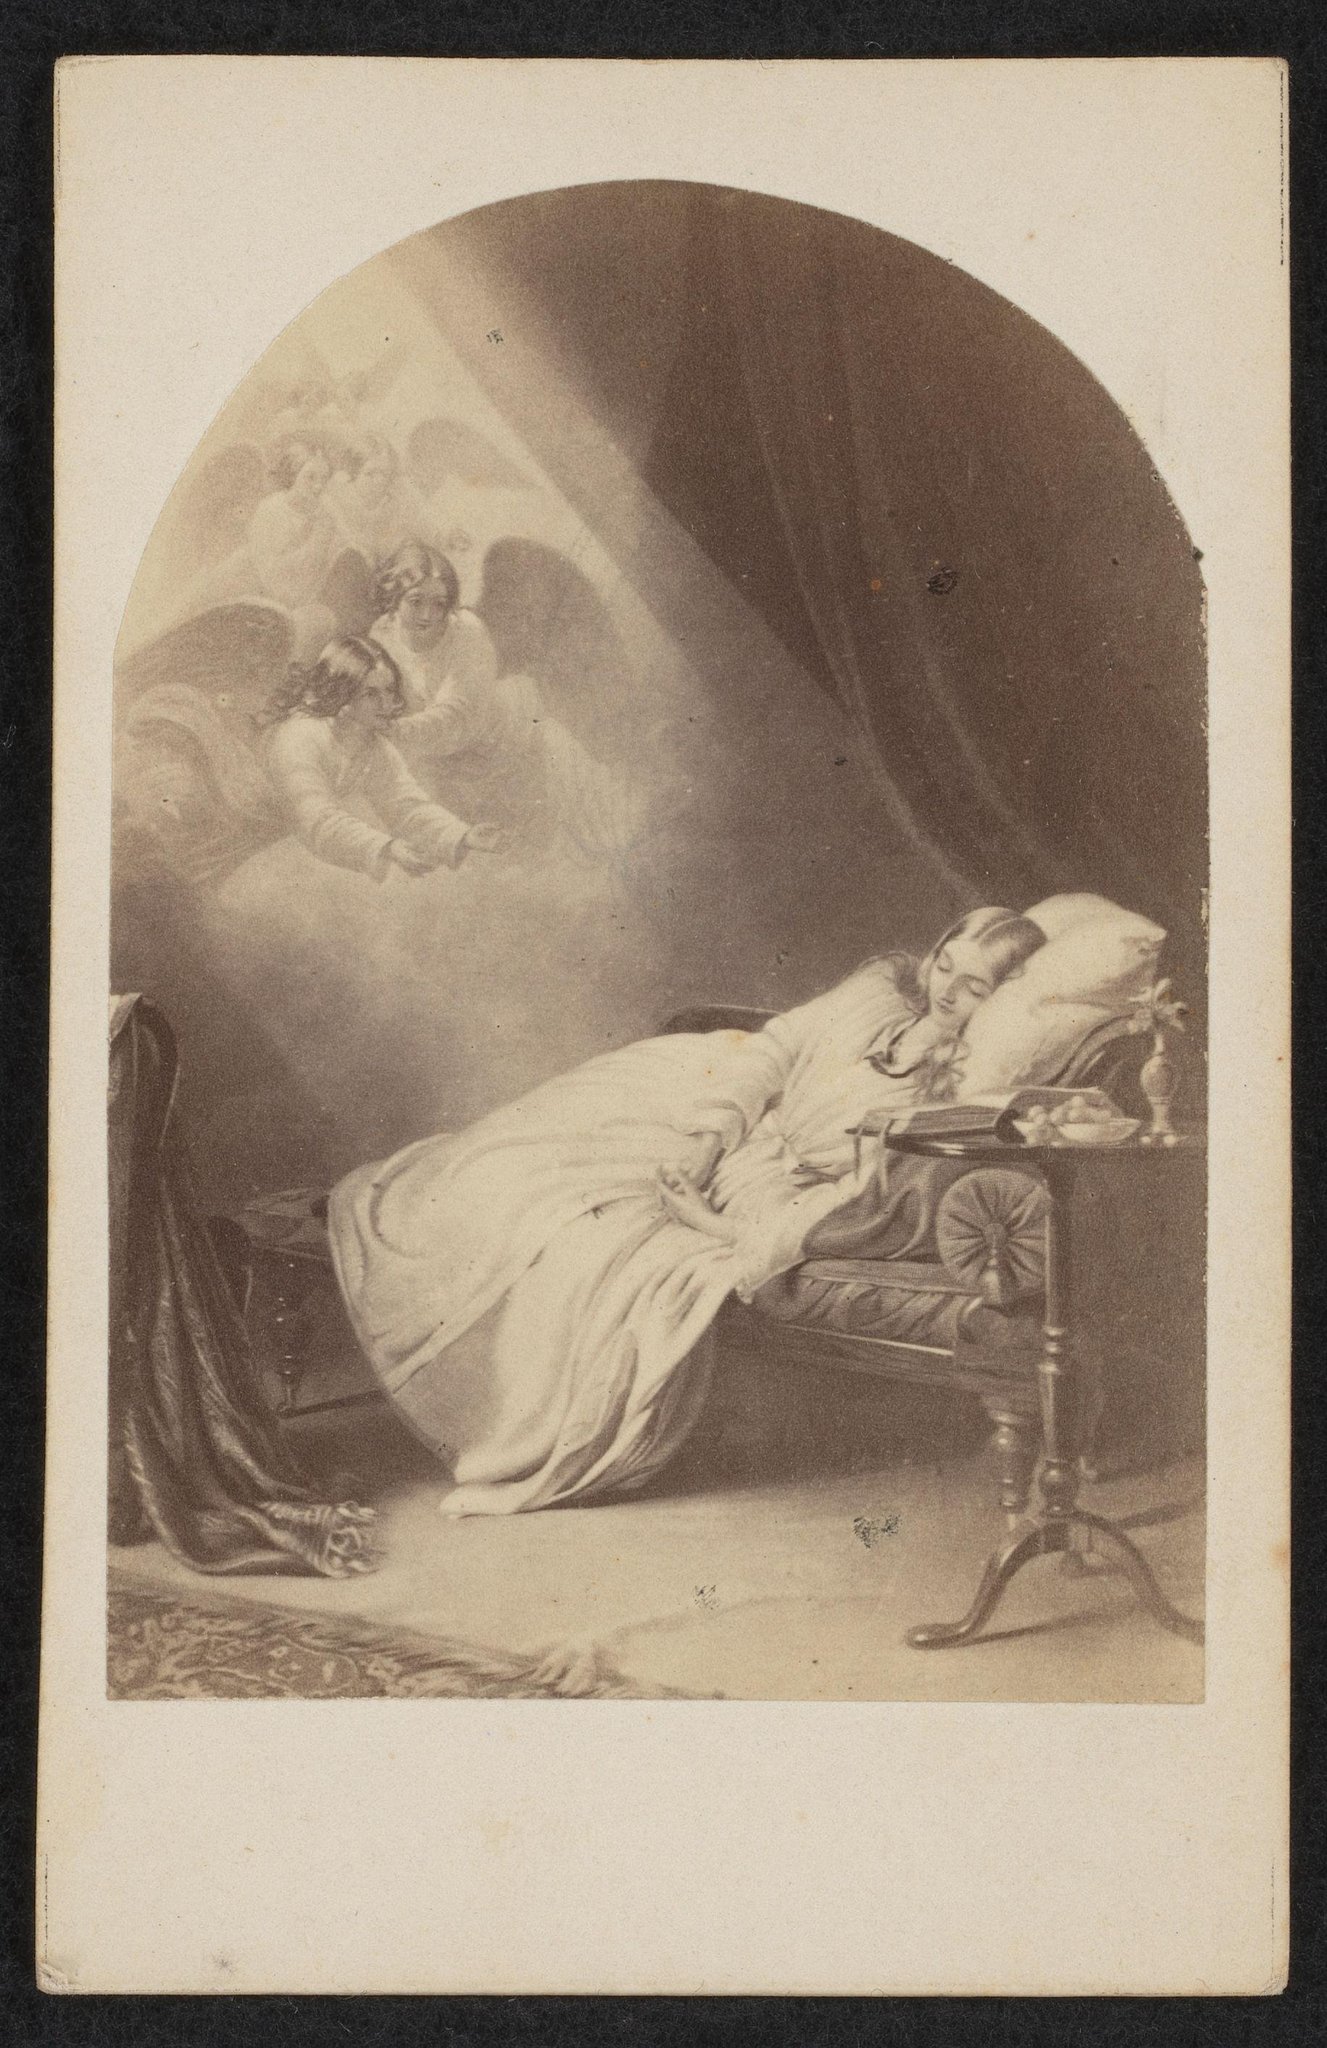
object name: photograph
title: Fotoreproductie van een schilderij, engelen lokken liggende jonge vrouw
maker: Anonymous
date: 1860-1900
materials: cardboard, photographic support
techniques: albumen print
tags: lying on one side, stretched out, angels